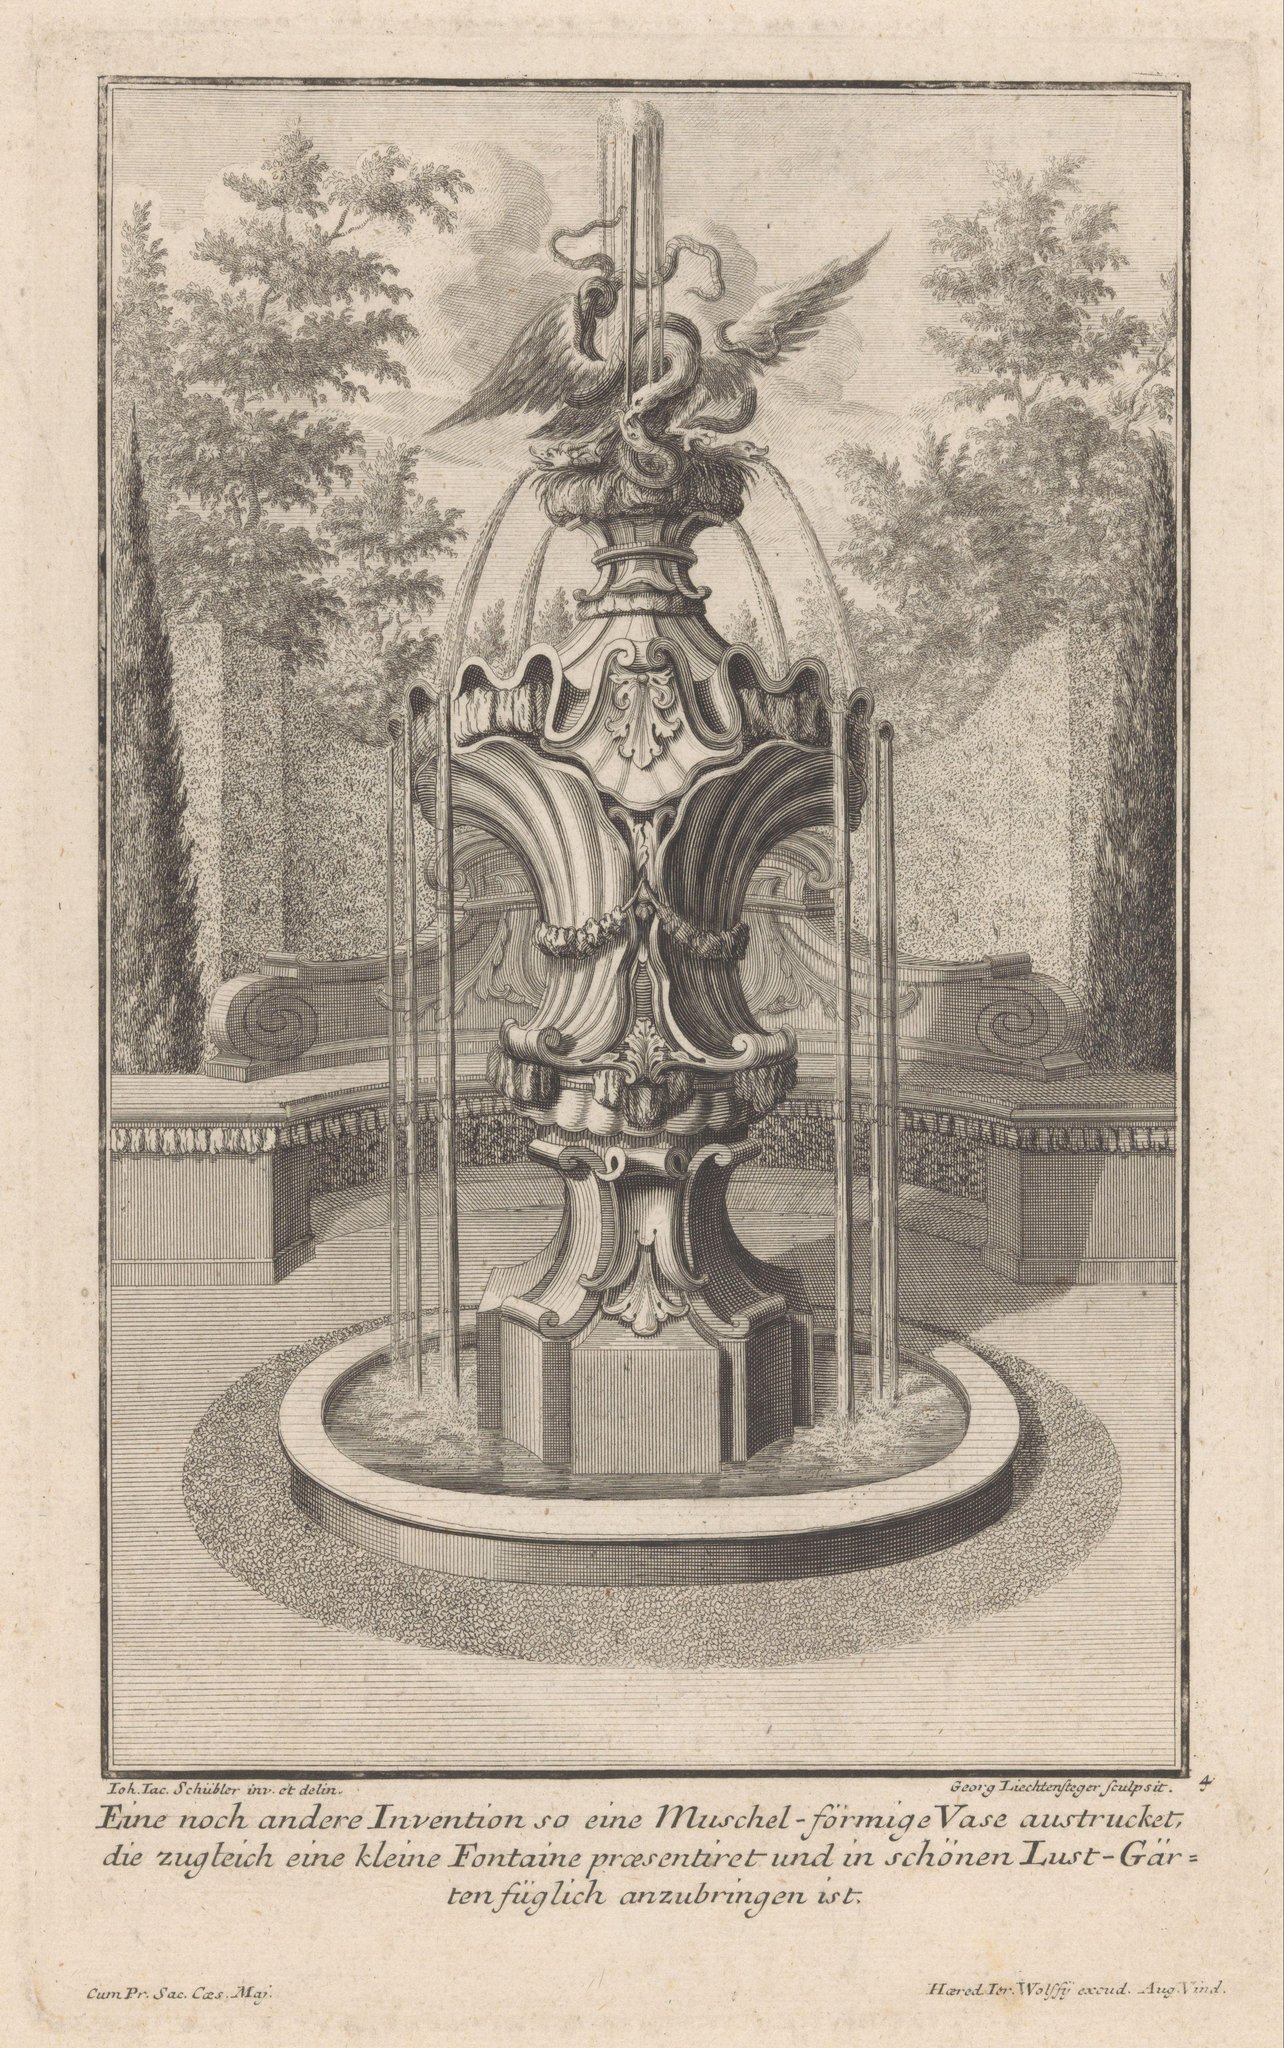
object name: print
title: Johann Jacob Schüblers Sechzehende Ausgabe seines vorhabenden Wercks, Worinnen vorgezeigt werden Sechs Neu-inventirte Vases (...)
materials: paper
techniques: engraving, etching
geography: augsburg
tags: snakes, predatory birds: eagle, garden fountain, garden vase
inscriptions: collector's mark: Lugt 2228, collector's mark: Lugt 2760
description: In een tuin functioneert een geornamenteerde tuinvaas, gedecoreerd met een vechtende adelaar en slangen, als een fontein. In de achtergrond staat een halfronde bank. In de ondermarge een drieregelige Duitse tekst.